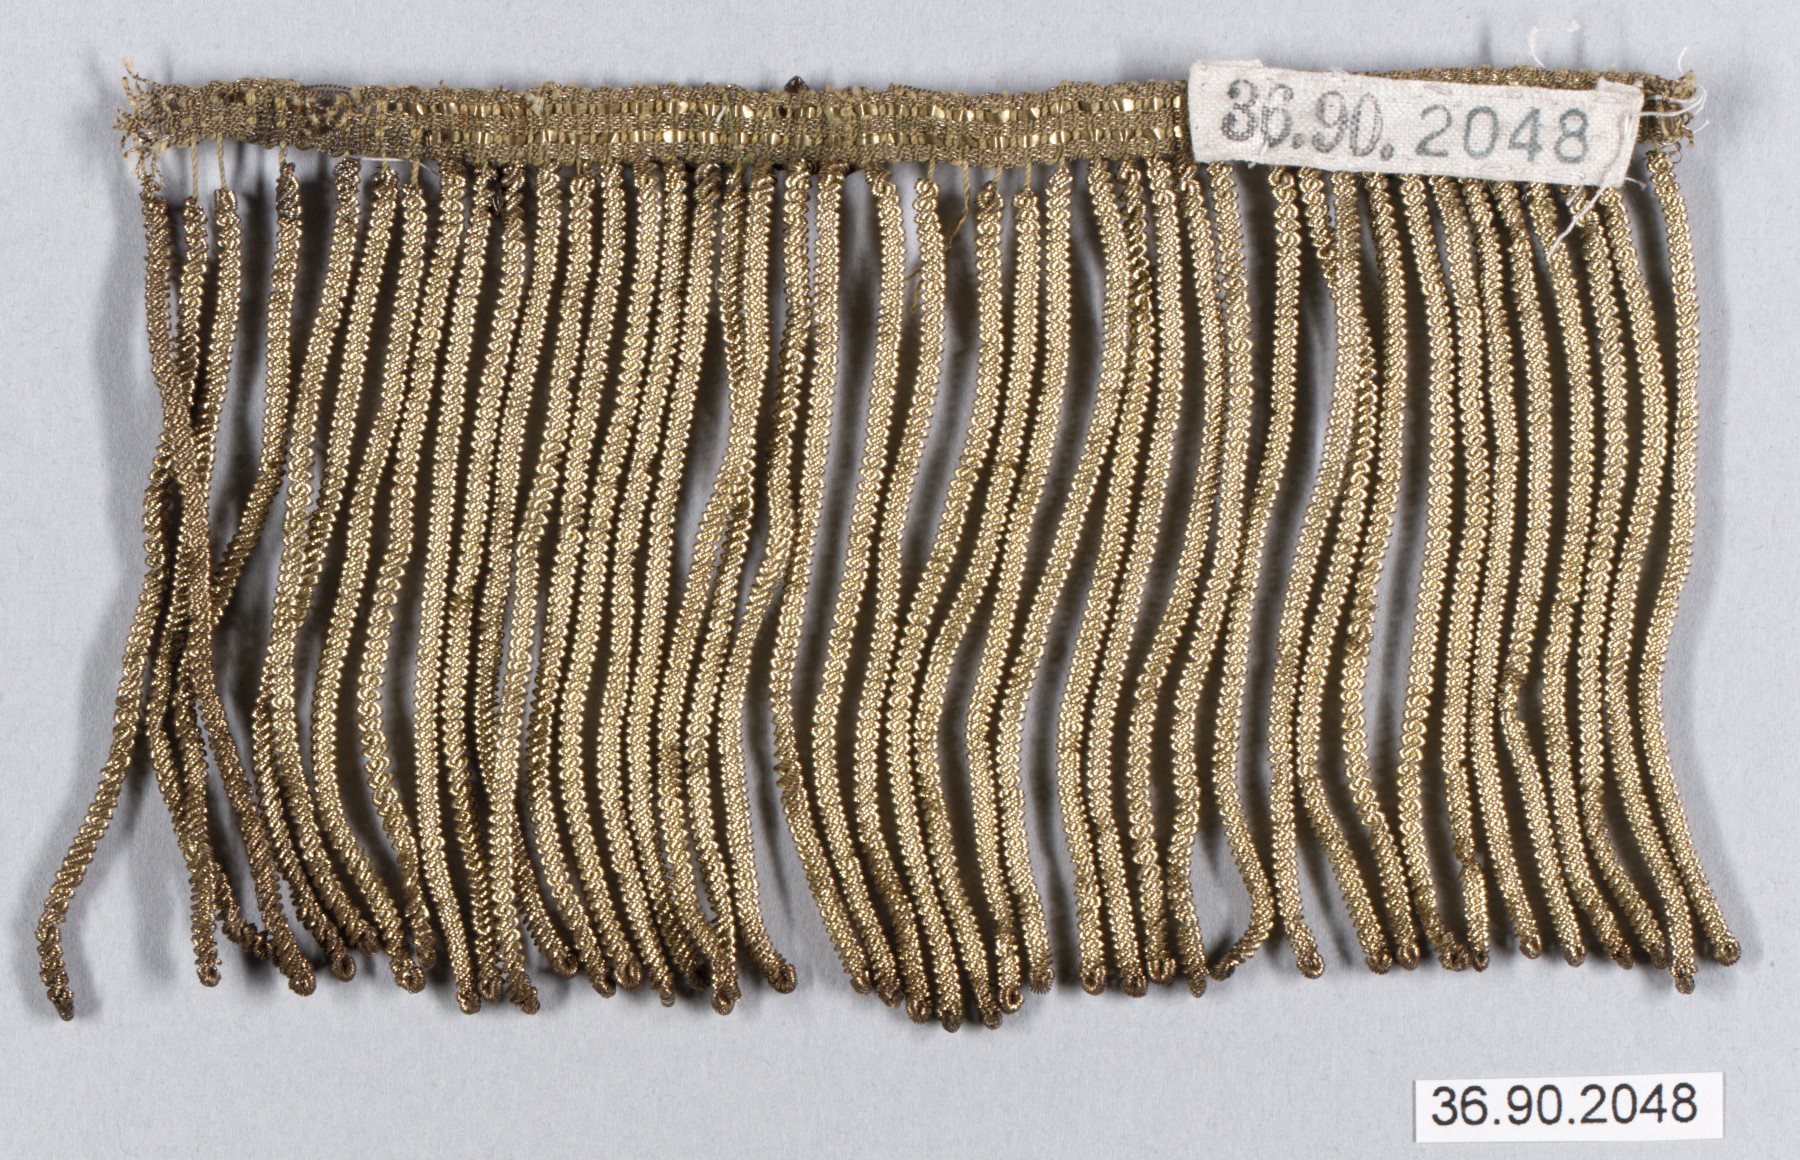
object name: fringe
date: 1801-1833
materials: silk